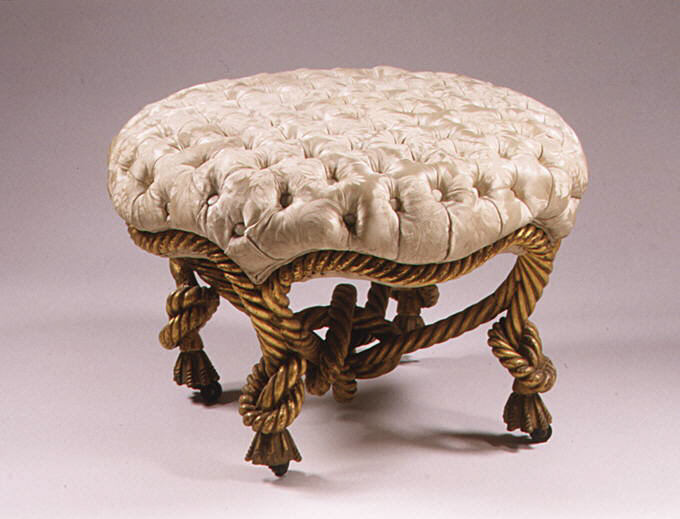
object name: stool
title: Four-legged stool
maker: a. m. e. fournier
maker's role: maker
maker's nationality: french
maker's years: 1800-1900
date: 1851-1875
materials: brass, silver, wood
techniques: carving, damask, gilding